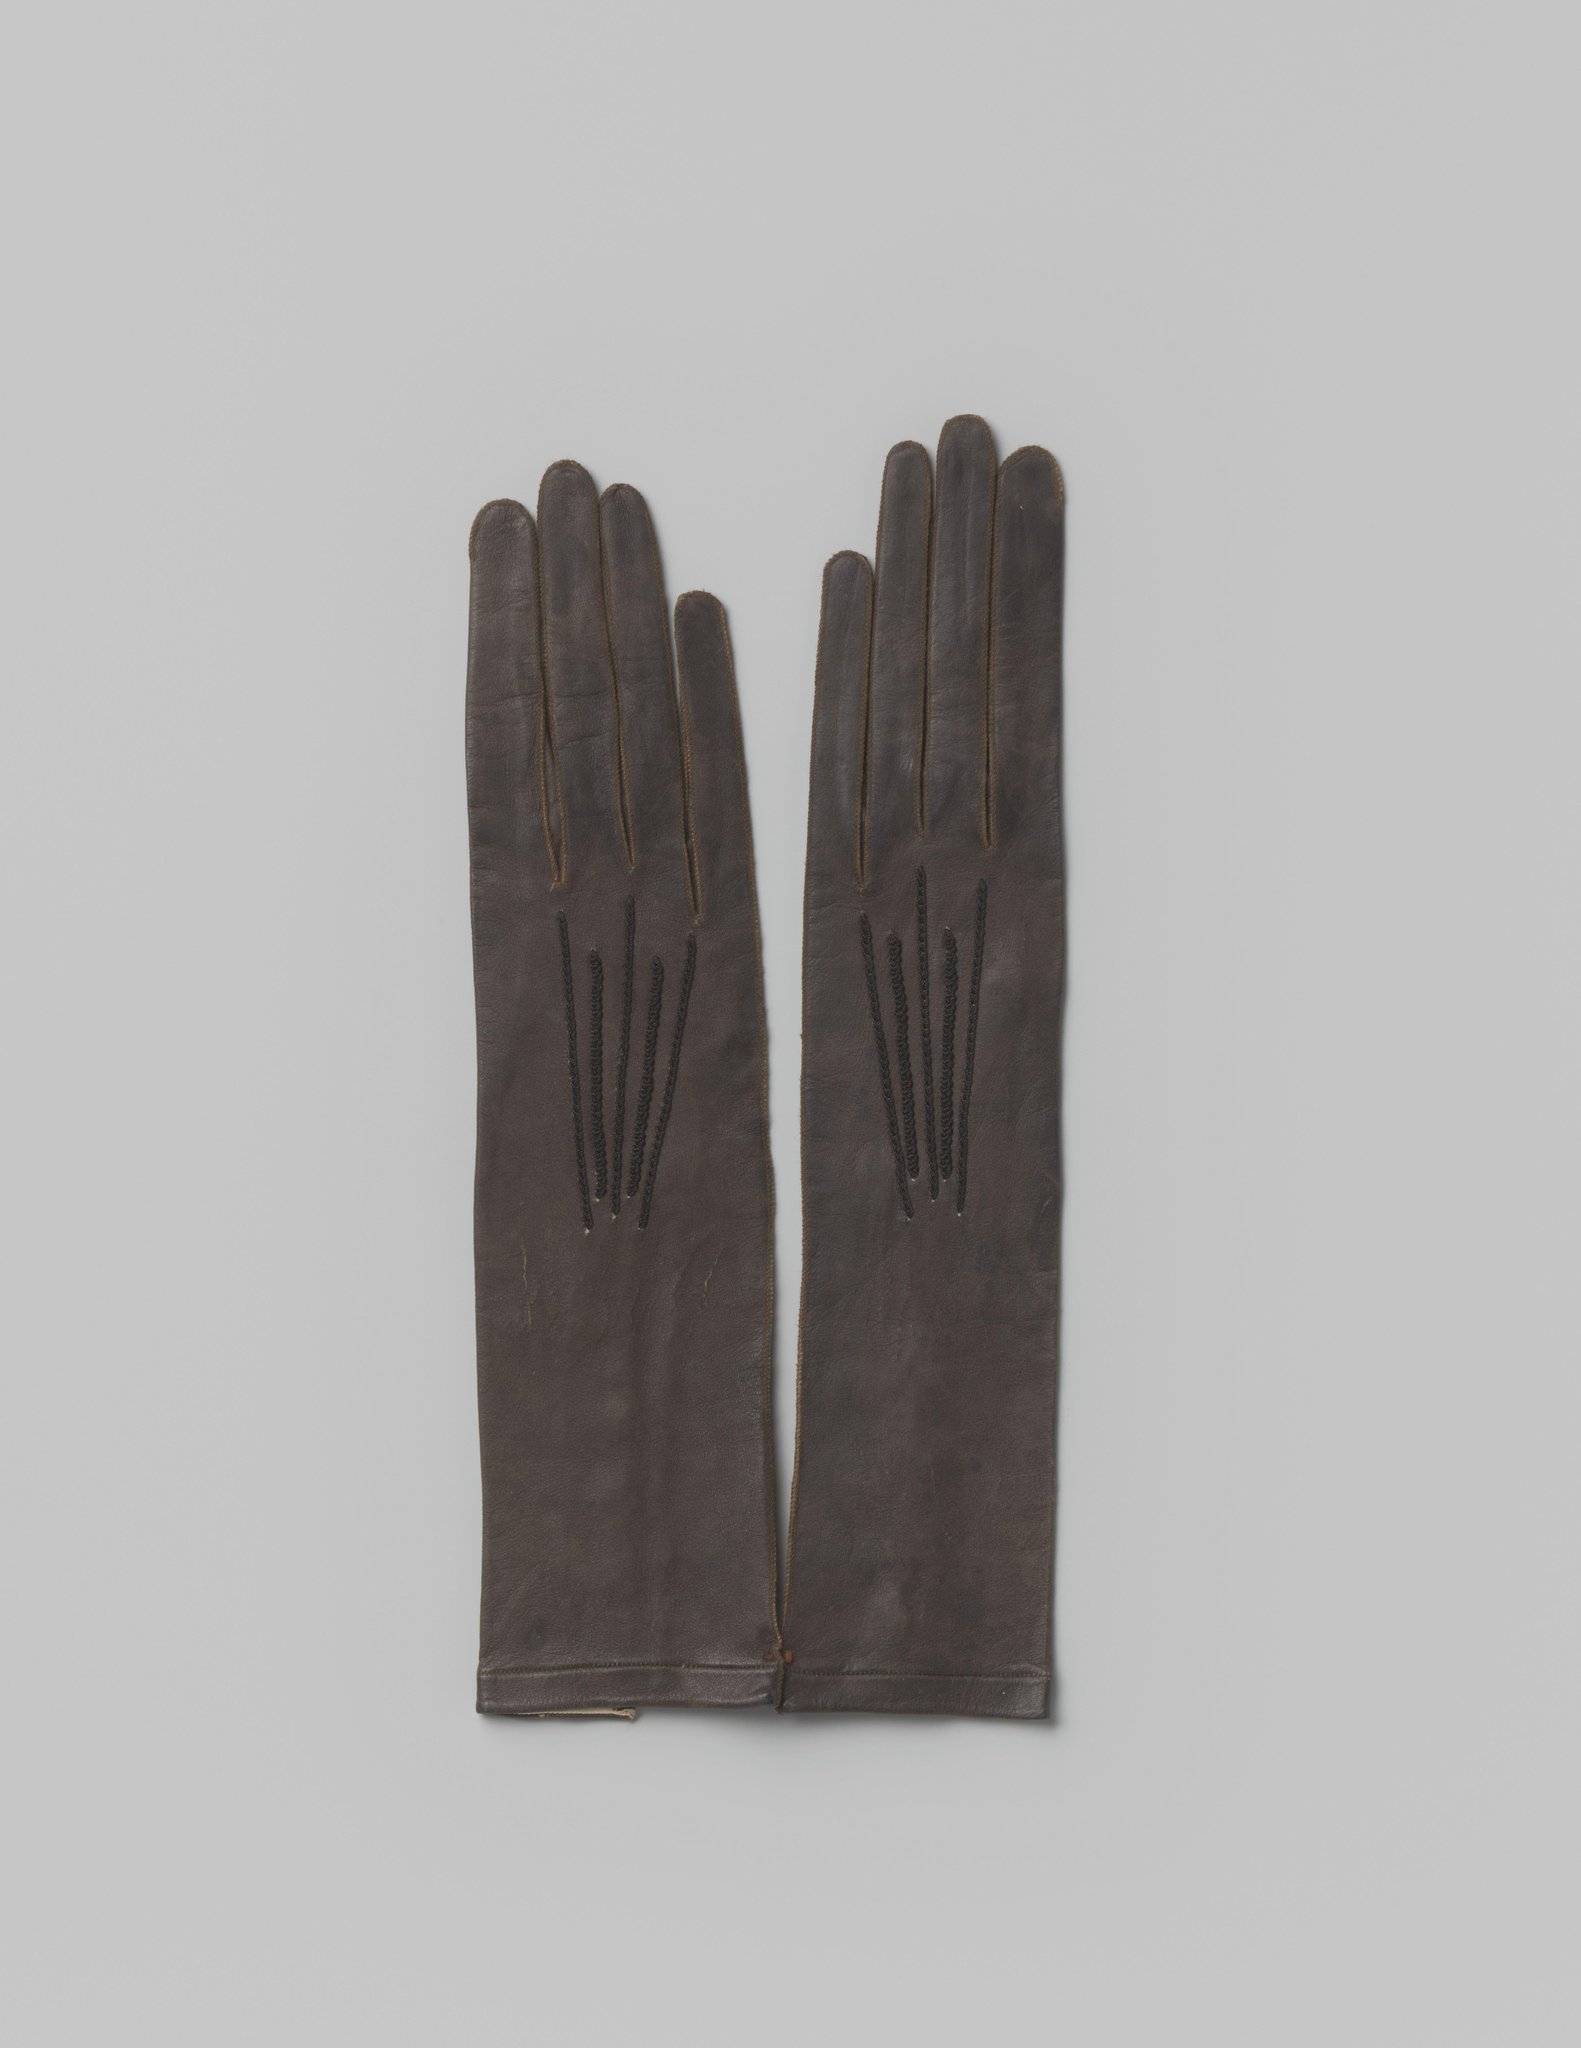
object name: glove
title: Handschoen van donkerbruin glacéleer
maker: Anonymous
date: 1900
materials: leather, metal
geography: western europe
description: Rechterhandschoen van donkerbruin glacéleer. Op de rug versierd met vijf zwarte lijnen. Bij de pols een split met vier metalen knopen. Met extra slanke vingers.